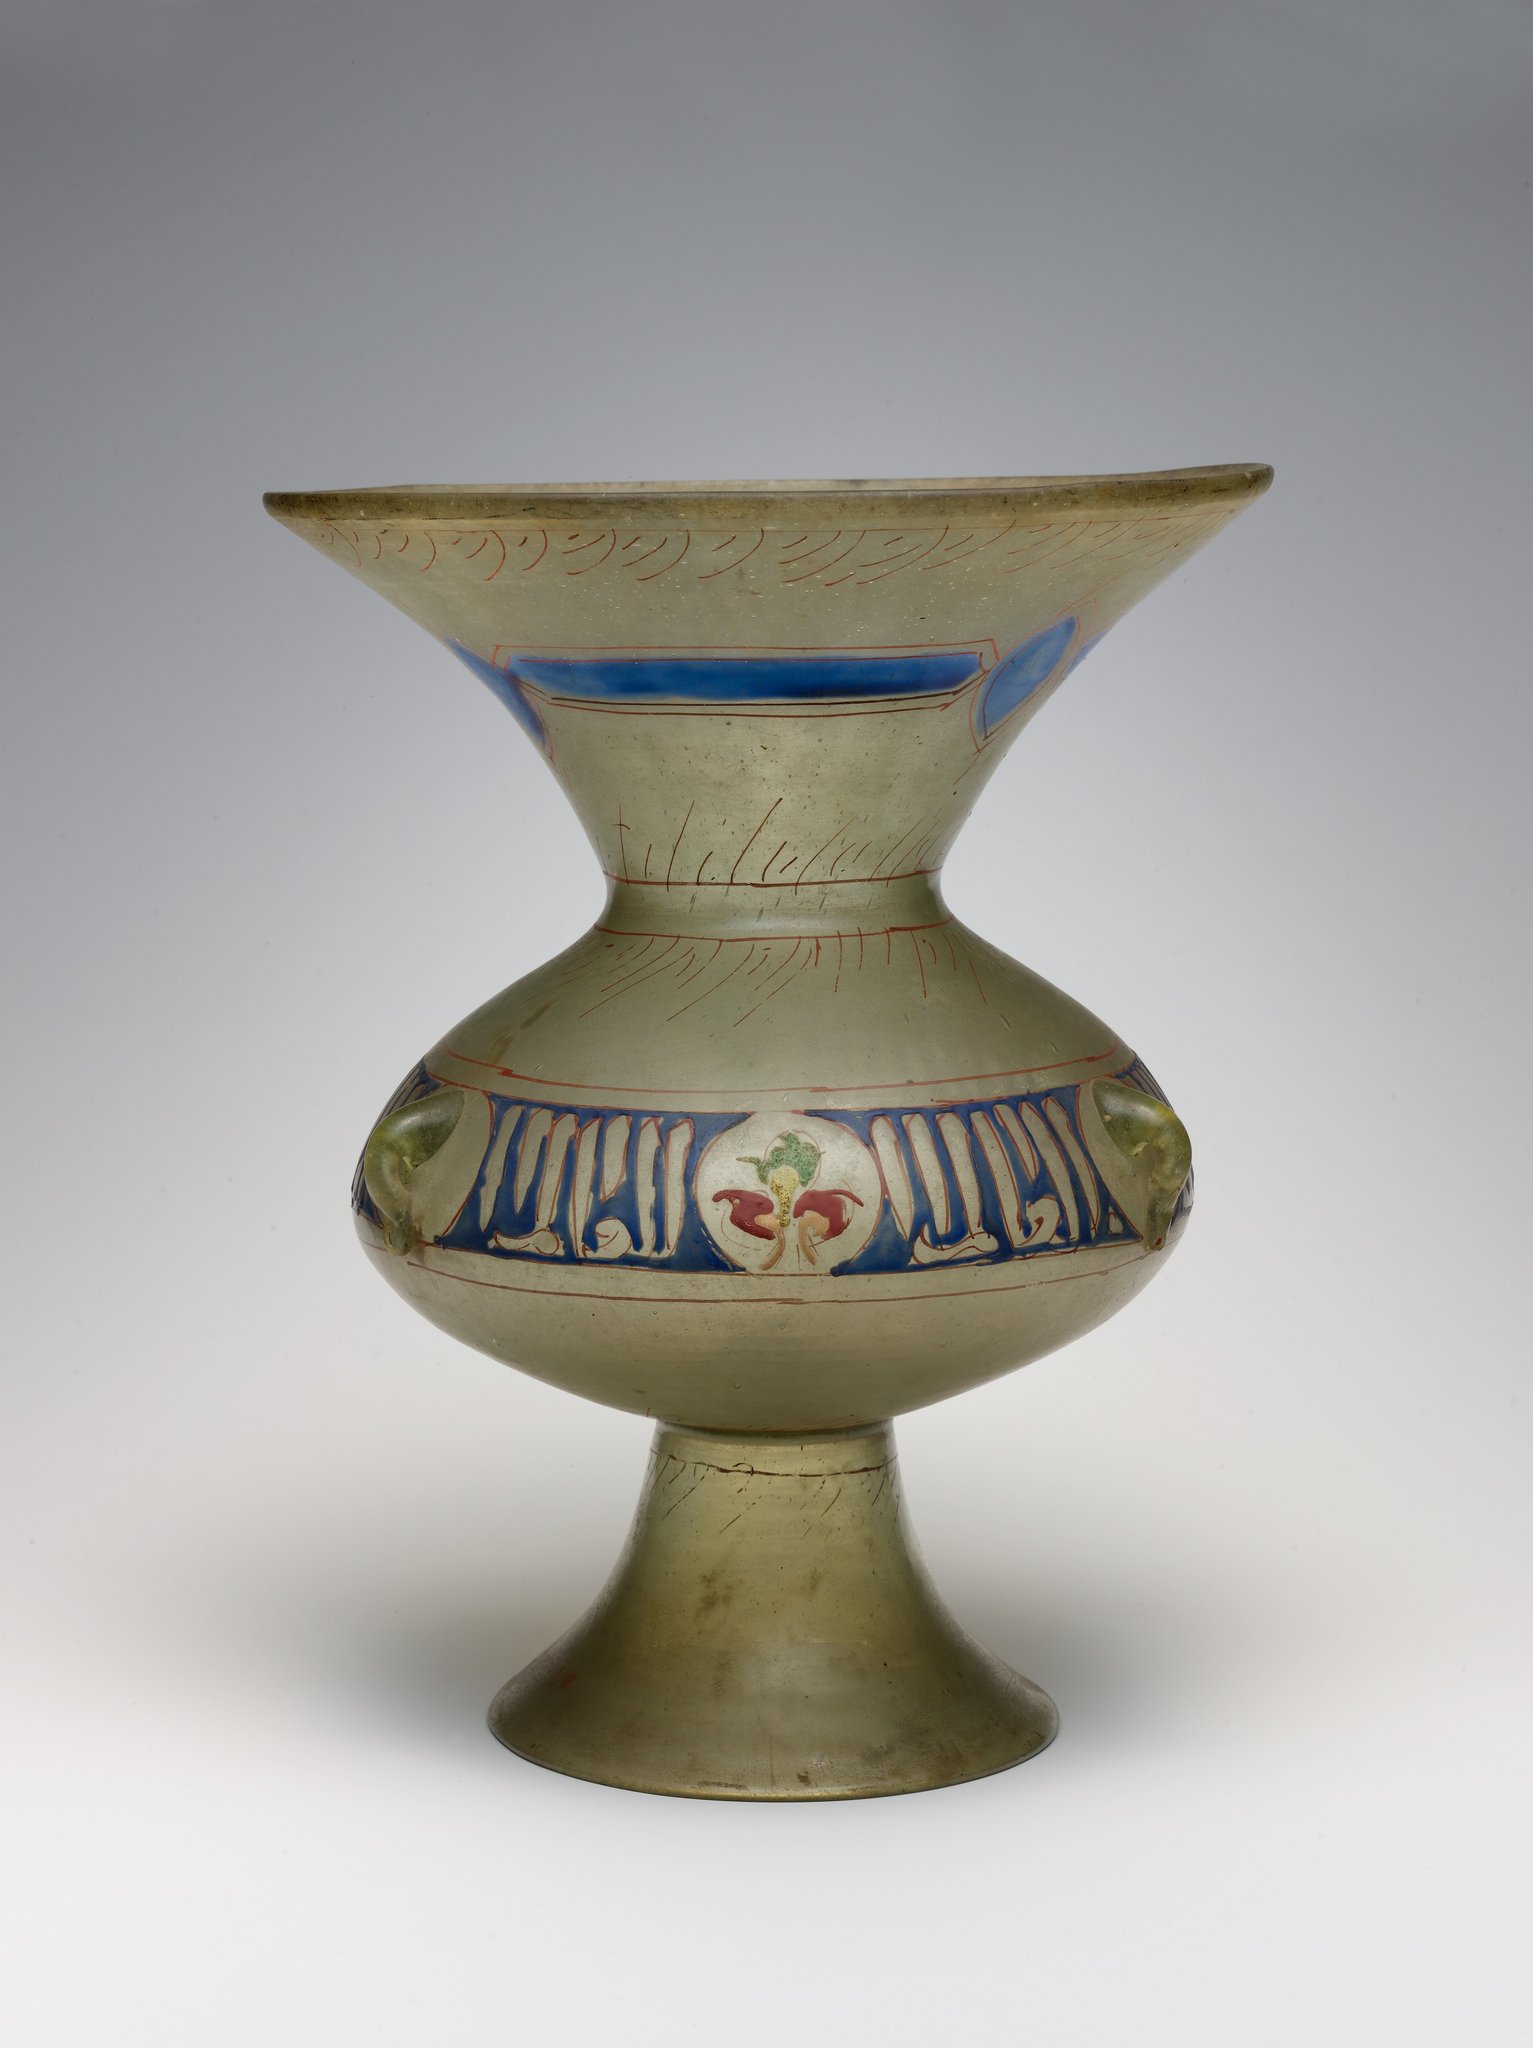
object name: mosque lamp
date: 1351-1400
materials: glass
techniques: enamel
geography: syria